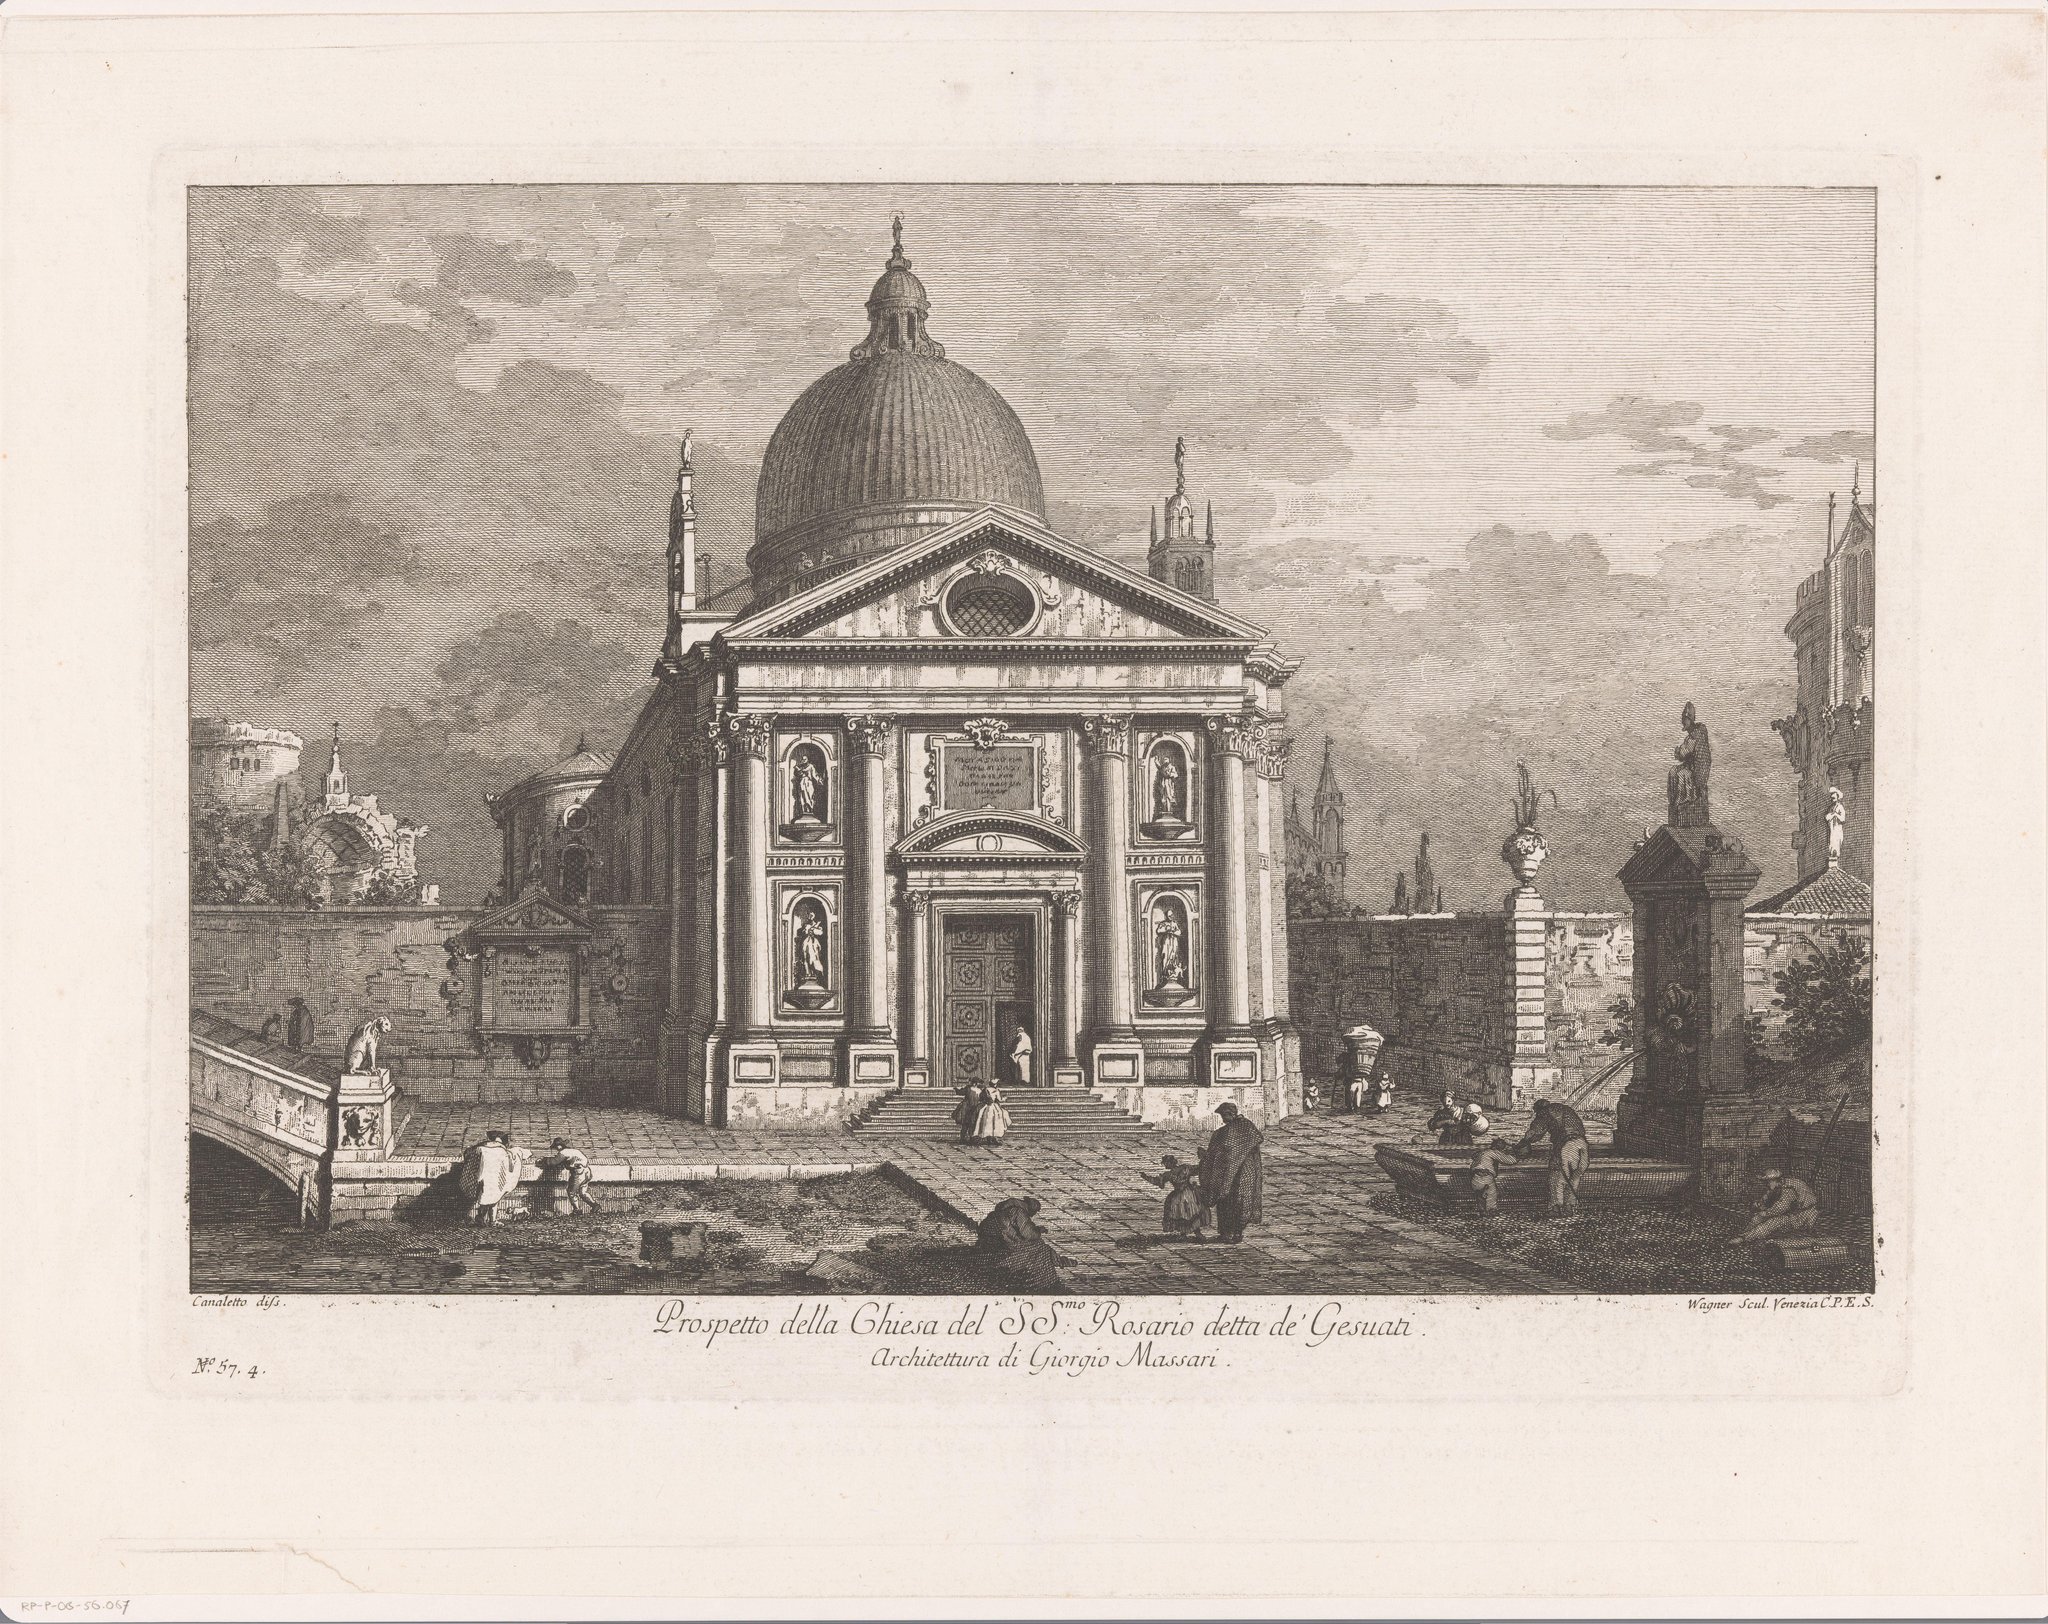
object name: print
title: Chiesa dei Gesuati te Venetië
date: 1739-1780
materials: paper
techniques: engraving, etching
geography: venice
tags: city-view in general; 'veduta', parts of church exterior and annexes: dome, parts of church exterior and annexes: façade, venice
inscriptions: collector's mark: Lugt 2228